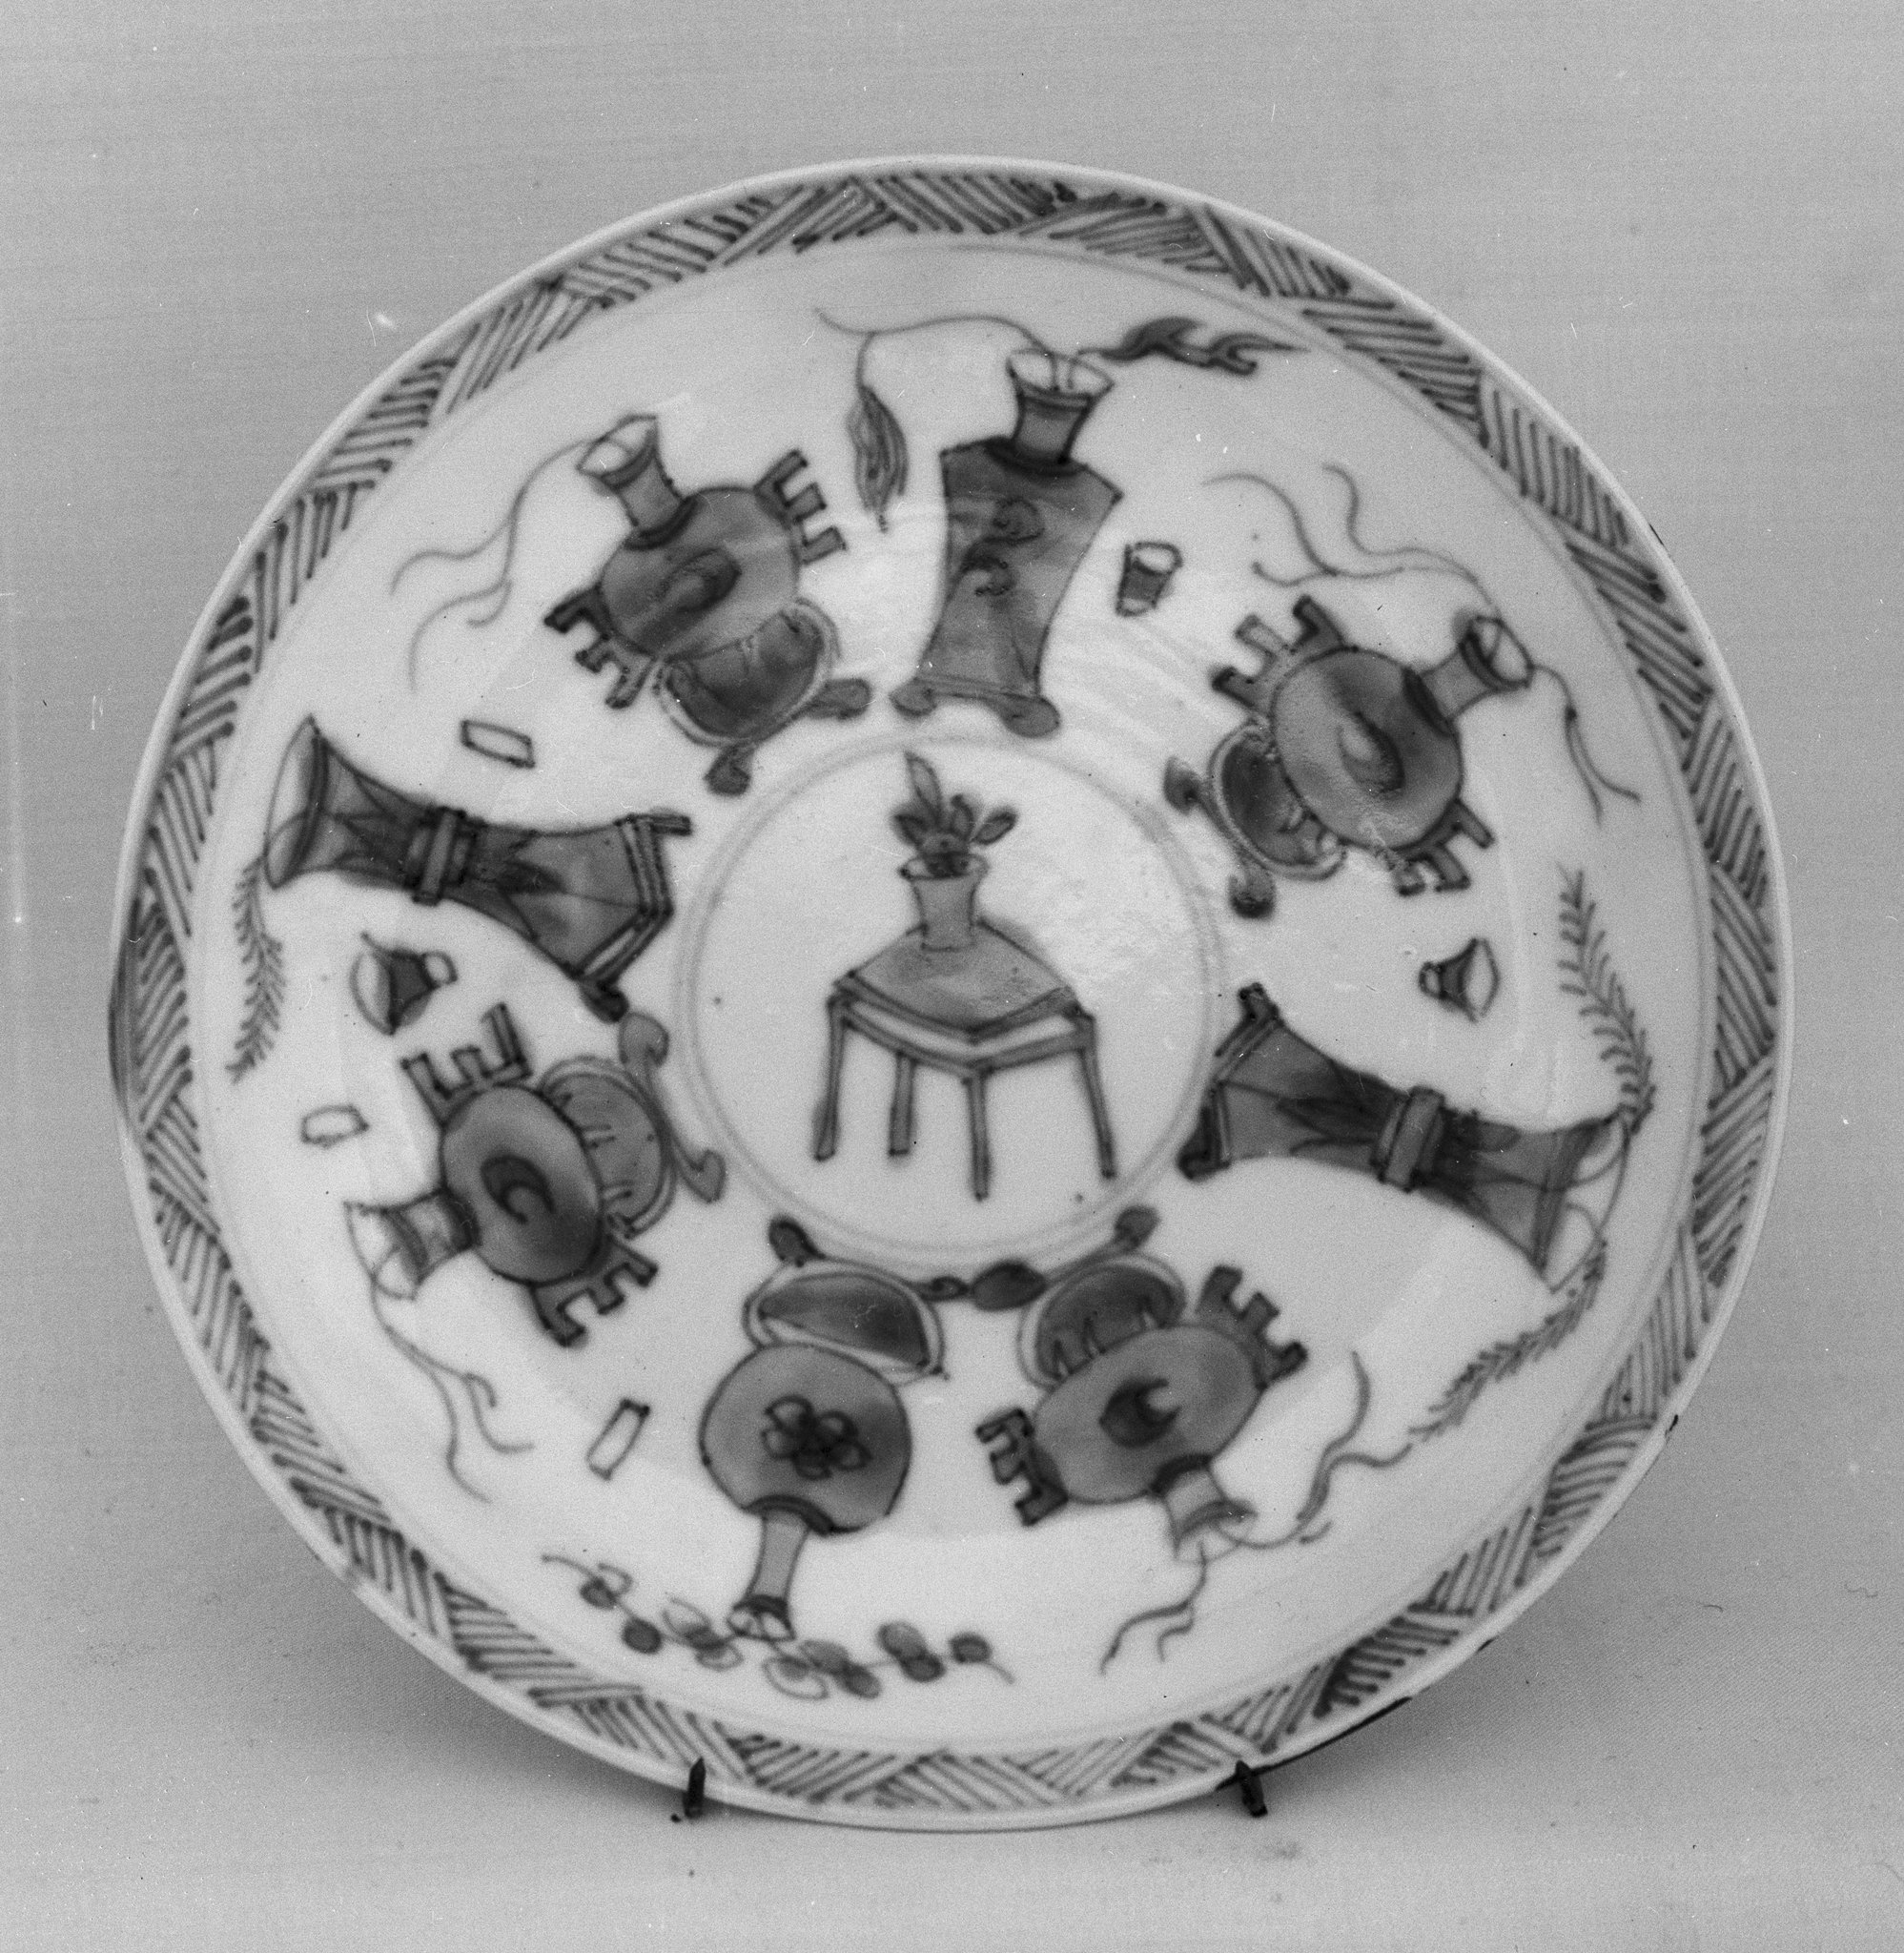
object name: saucer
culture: chinese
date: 1667-1733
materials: porcelain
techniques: painting, underglaze